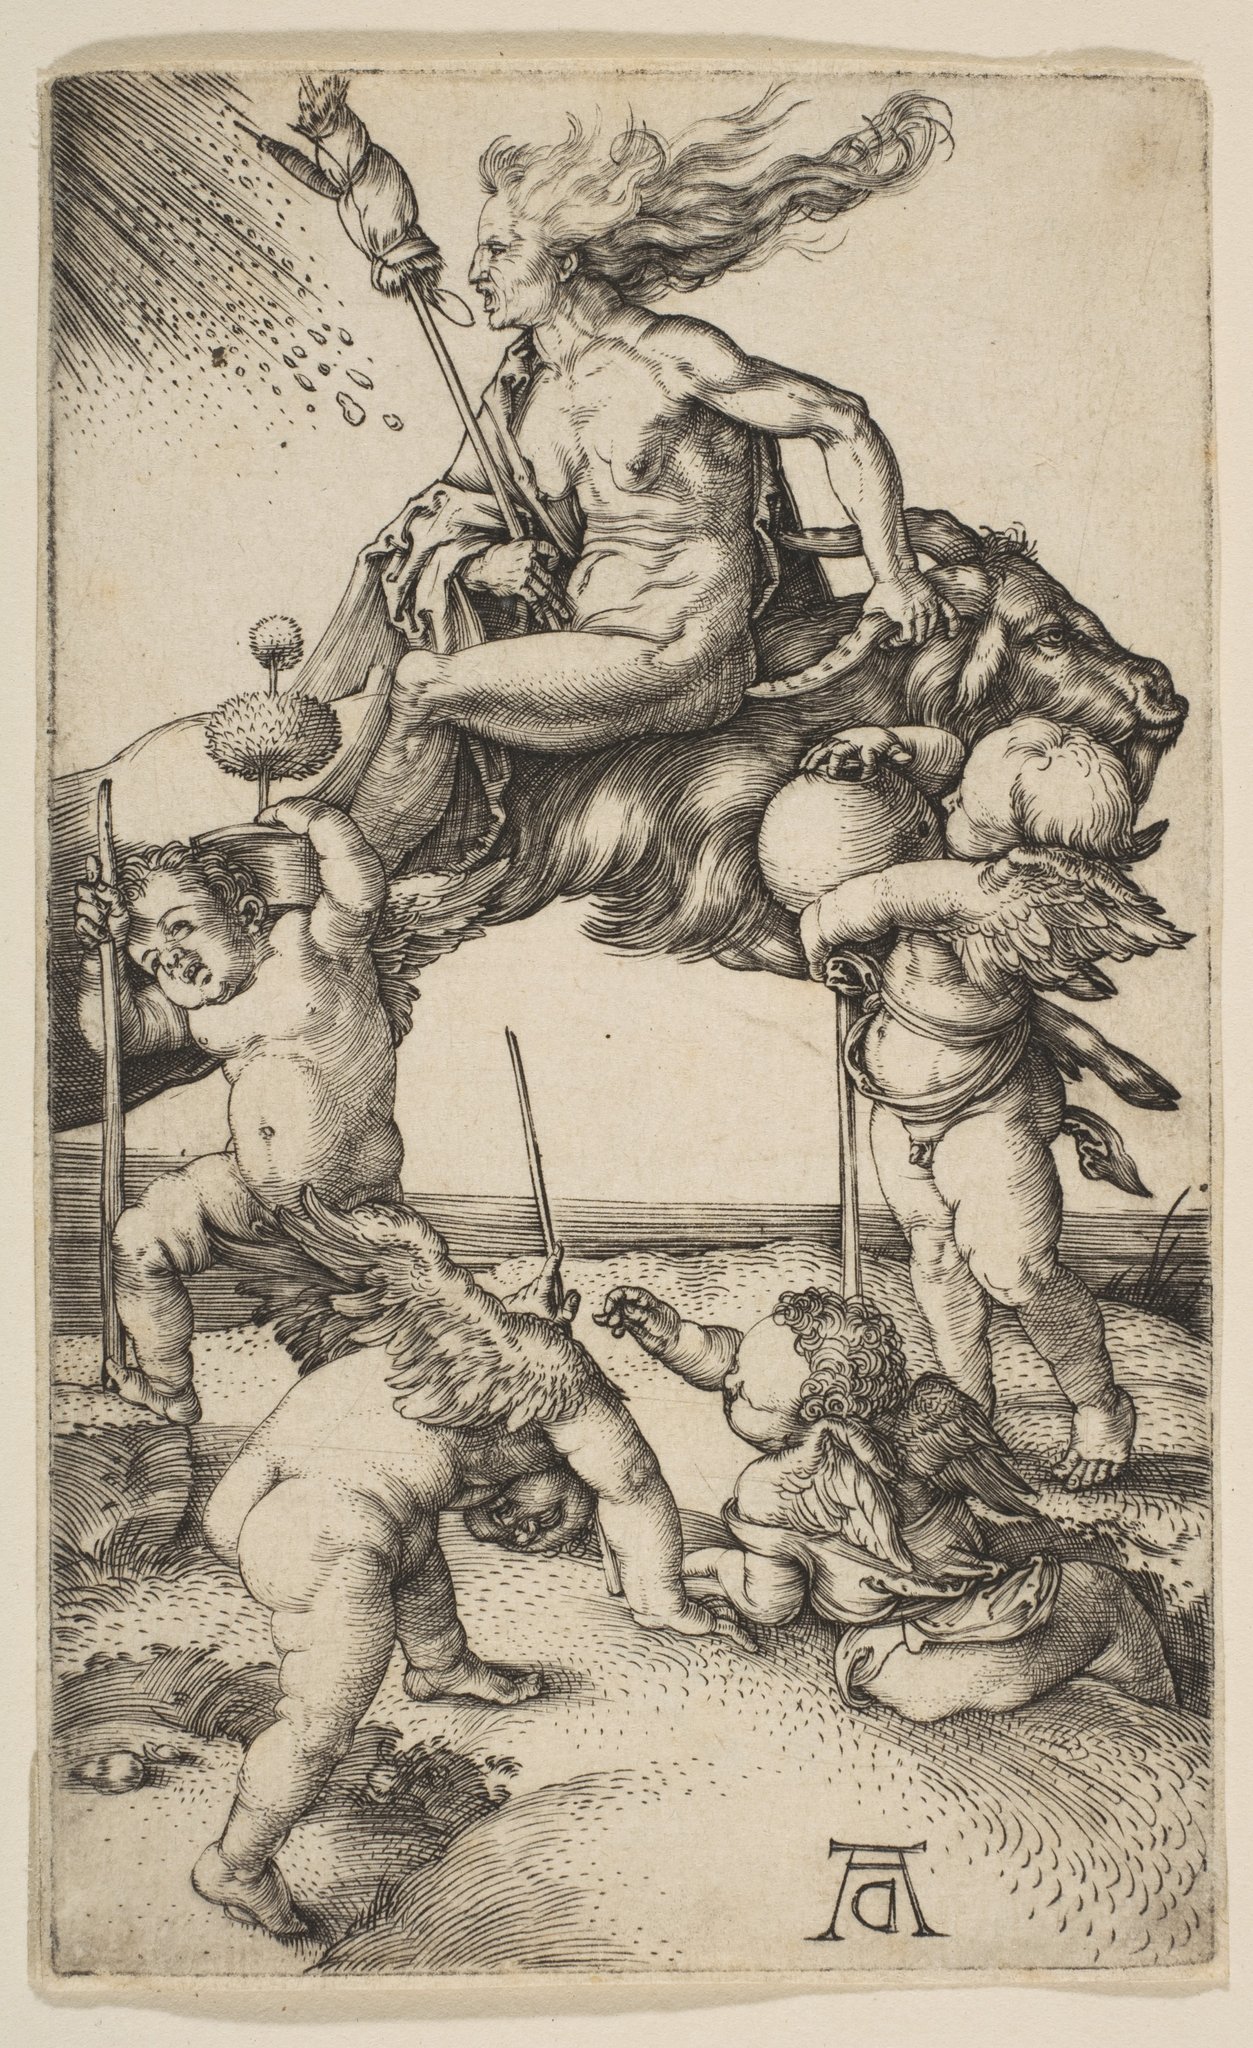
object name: print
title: The Witch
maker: albrecht dürer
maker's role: artist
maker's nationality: german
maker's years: 1471-1528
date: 1500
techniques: engraving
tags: animals,female nudes,putti,witches